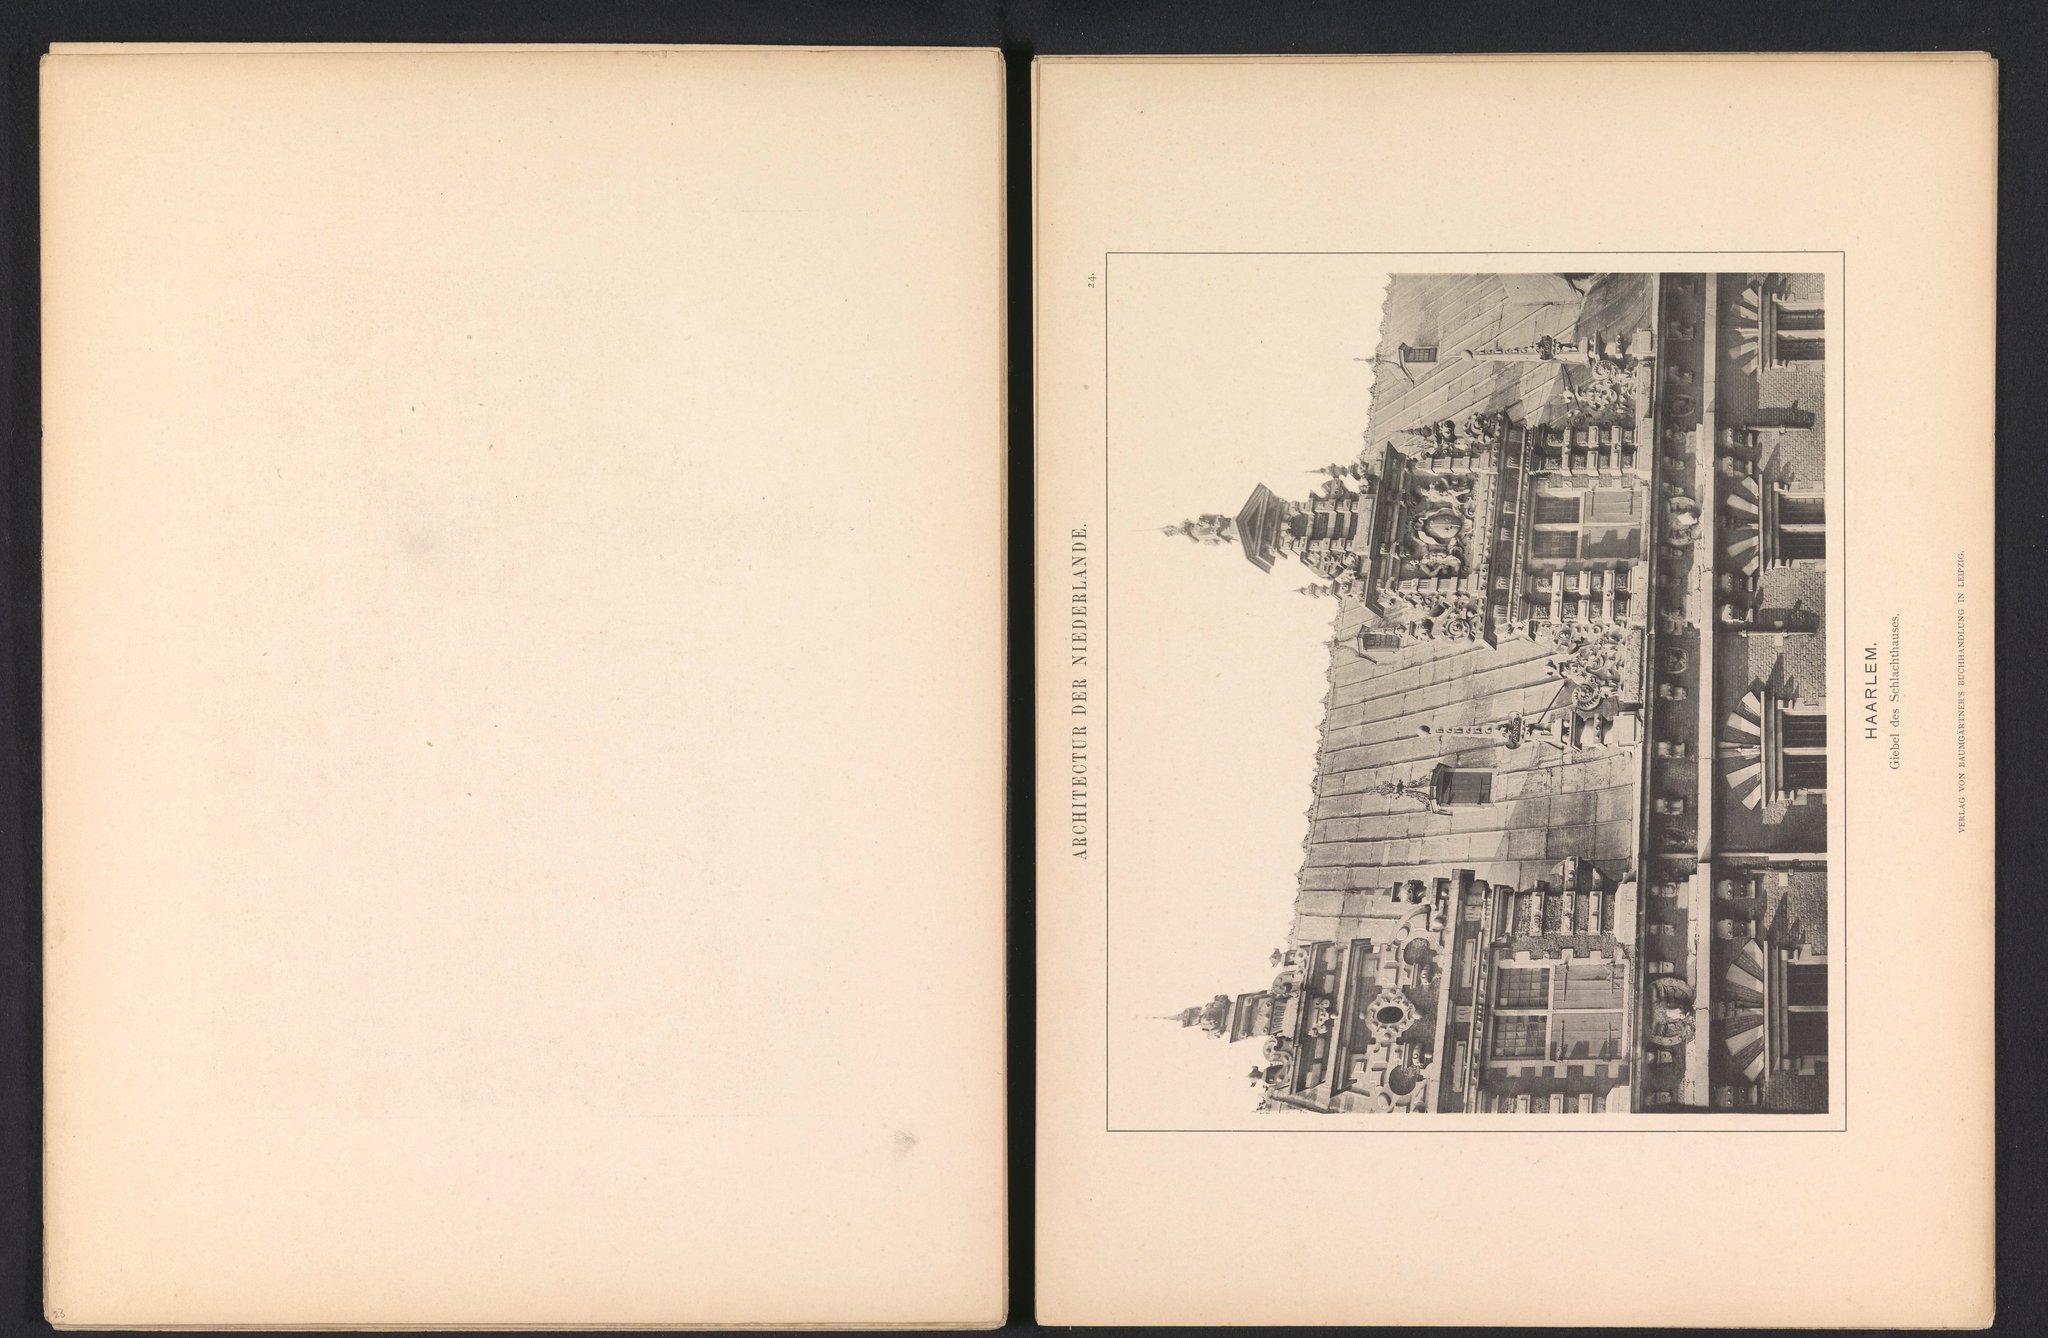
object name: page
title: Gezicht op de gevel van de vleeshal in Haarlem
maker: Anonymous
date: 1884-1894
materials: paper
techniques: photograph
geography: haarlem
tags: decorated gable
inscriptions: number: ‘24.’